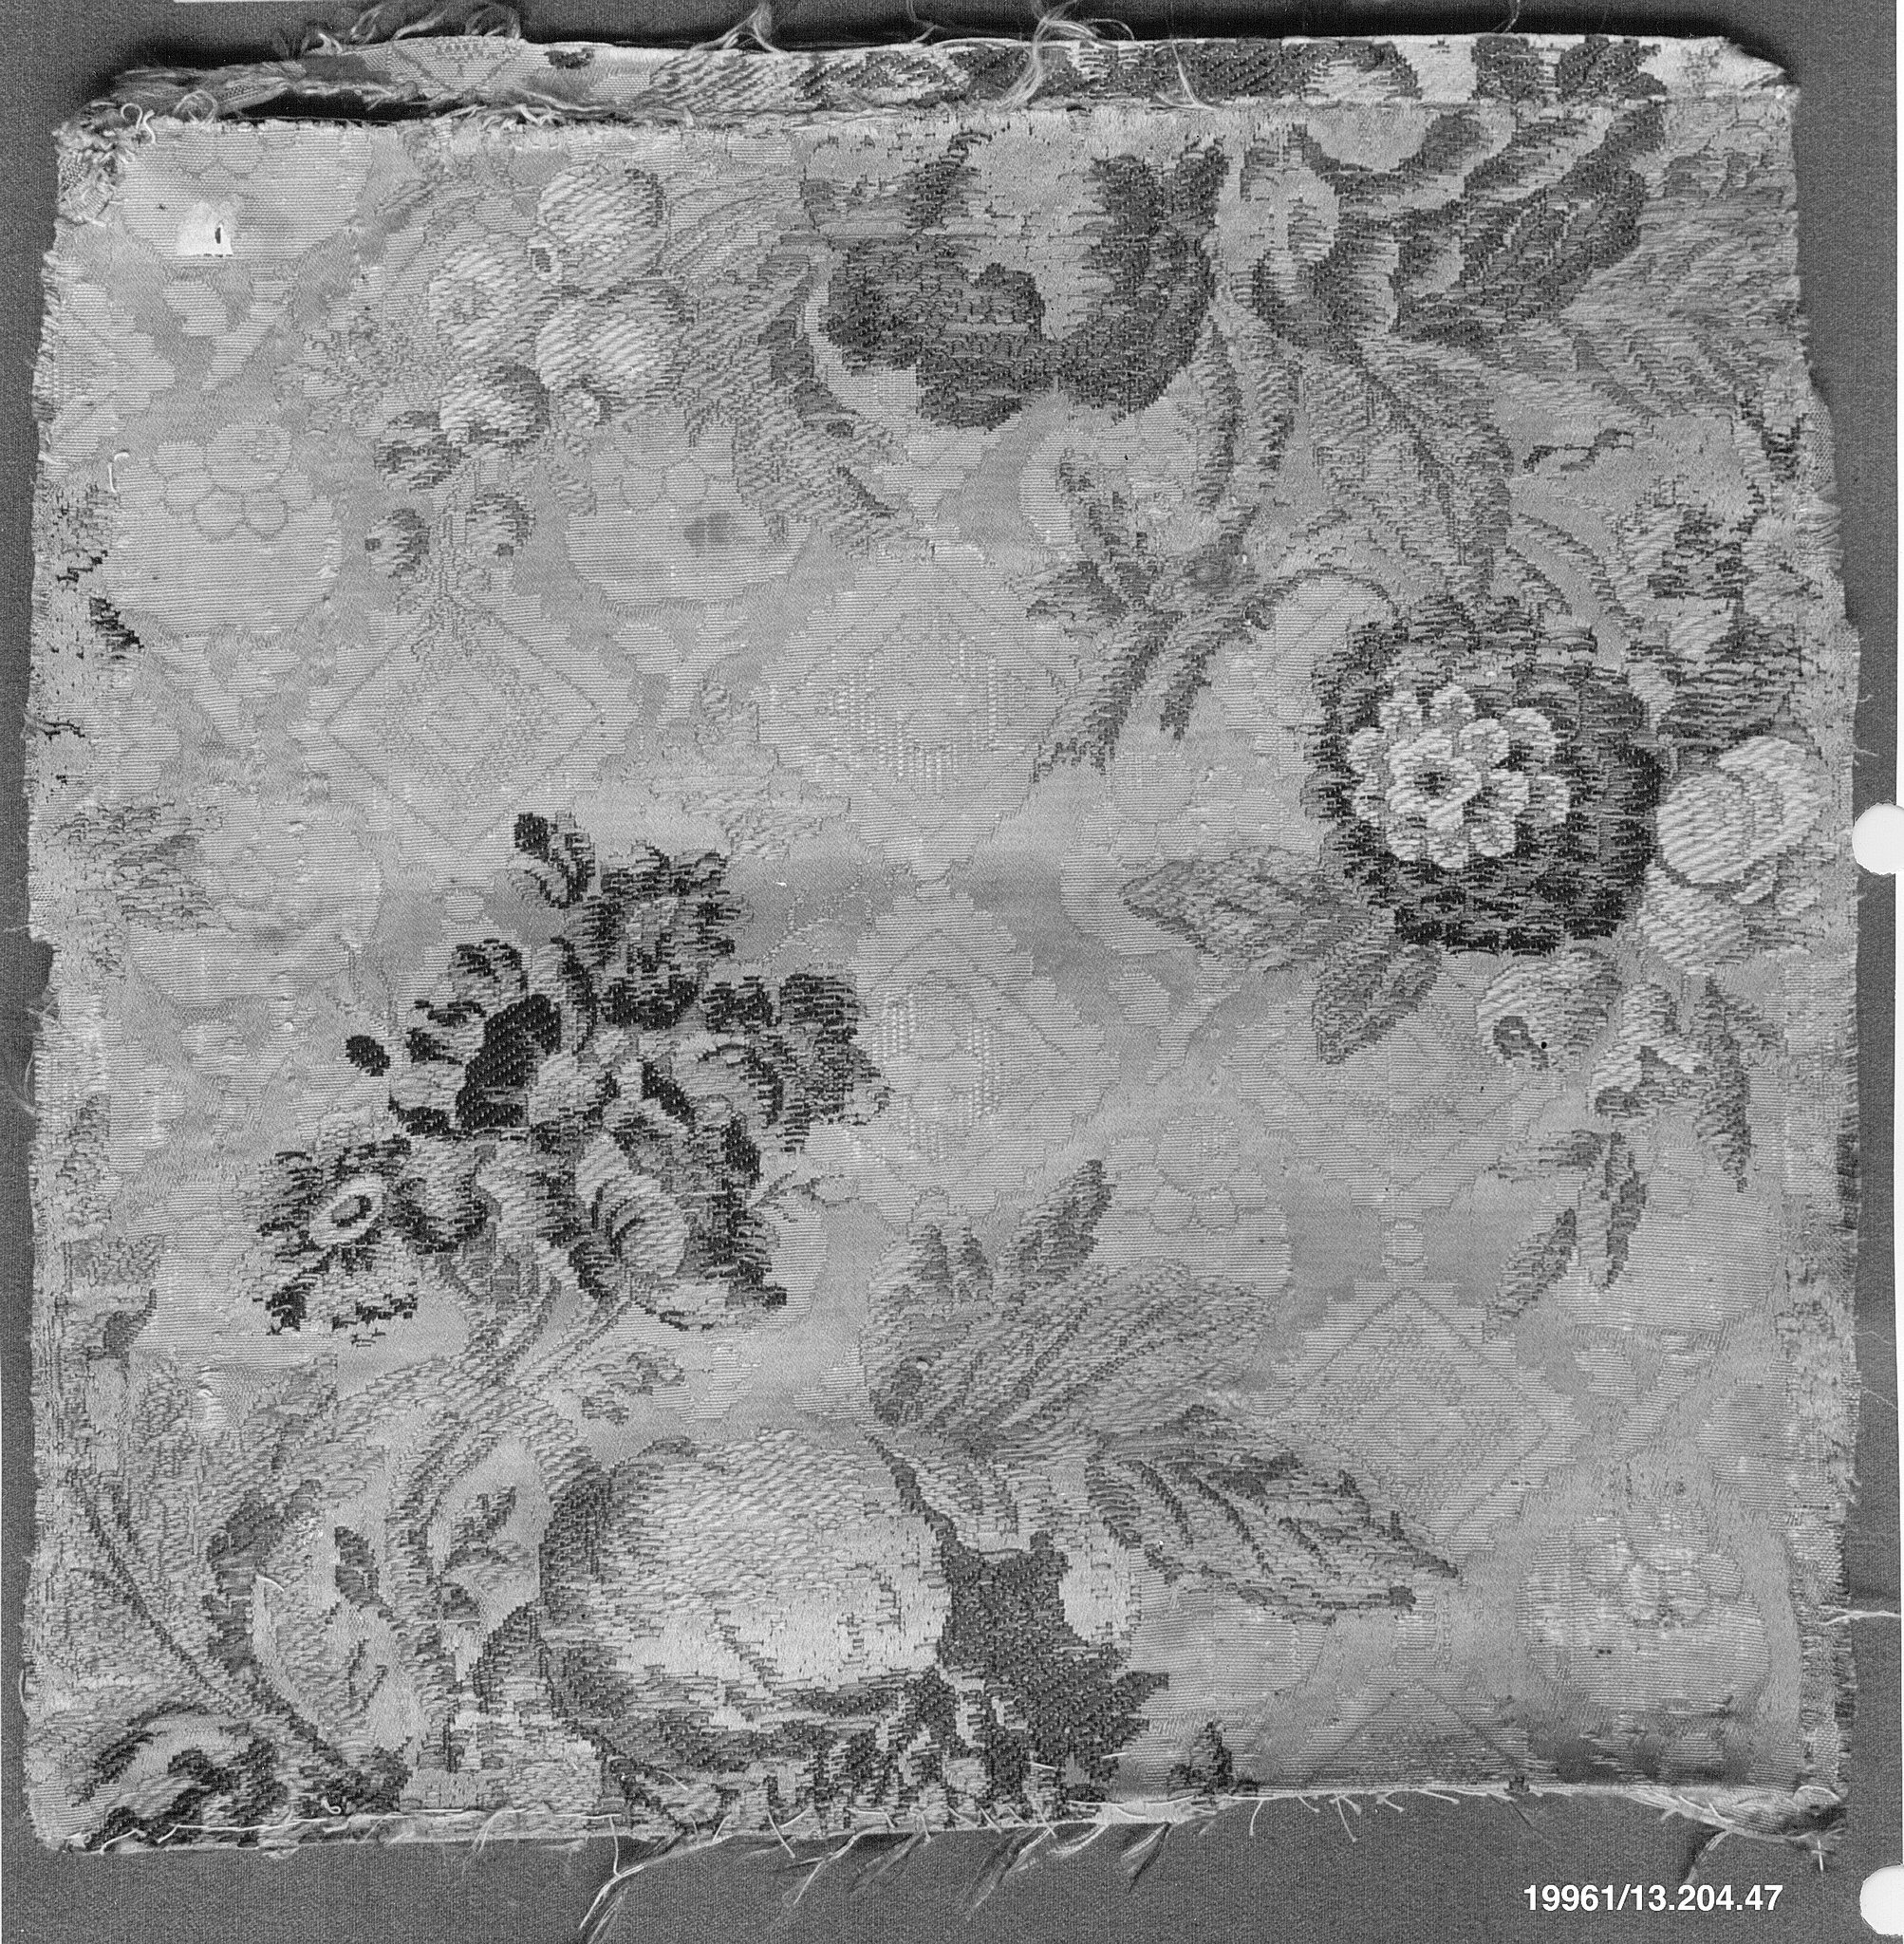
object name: piece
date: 1735-1740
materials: silk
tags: flowers,leaves